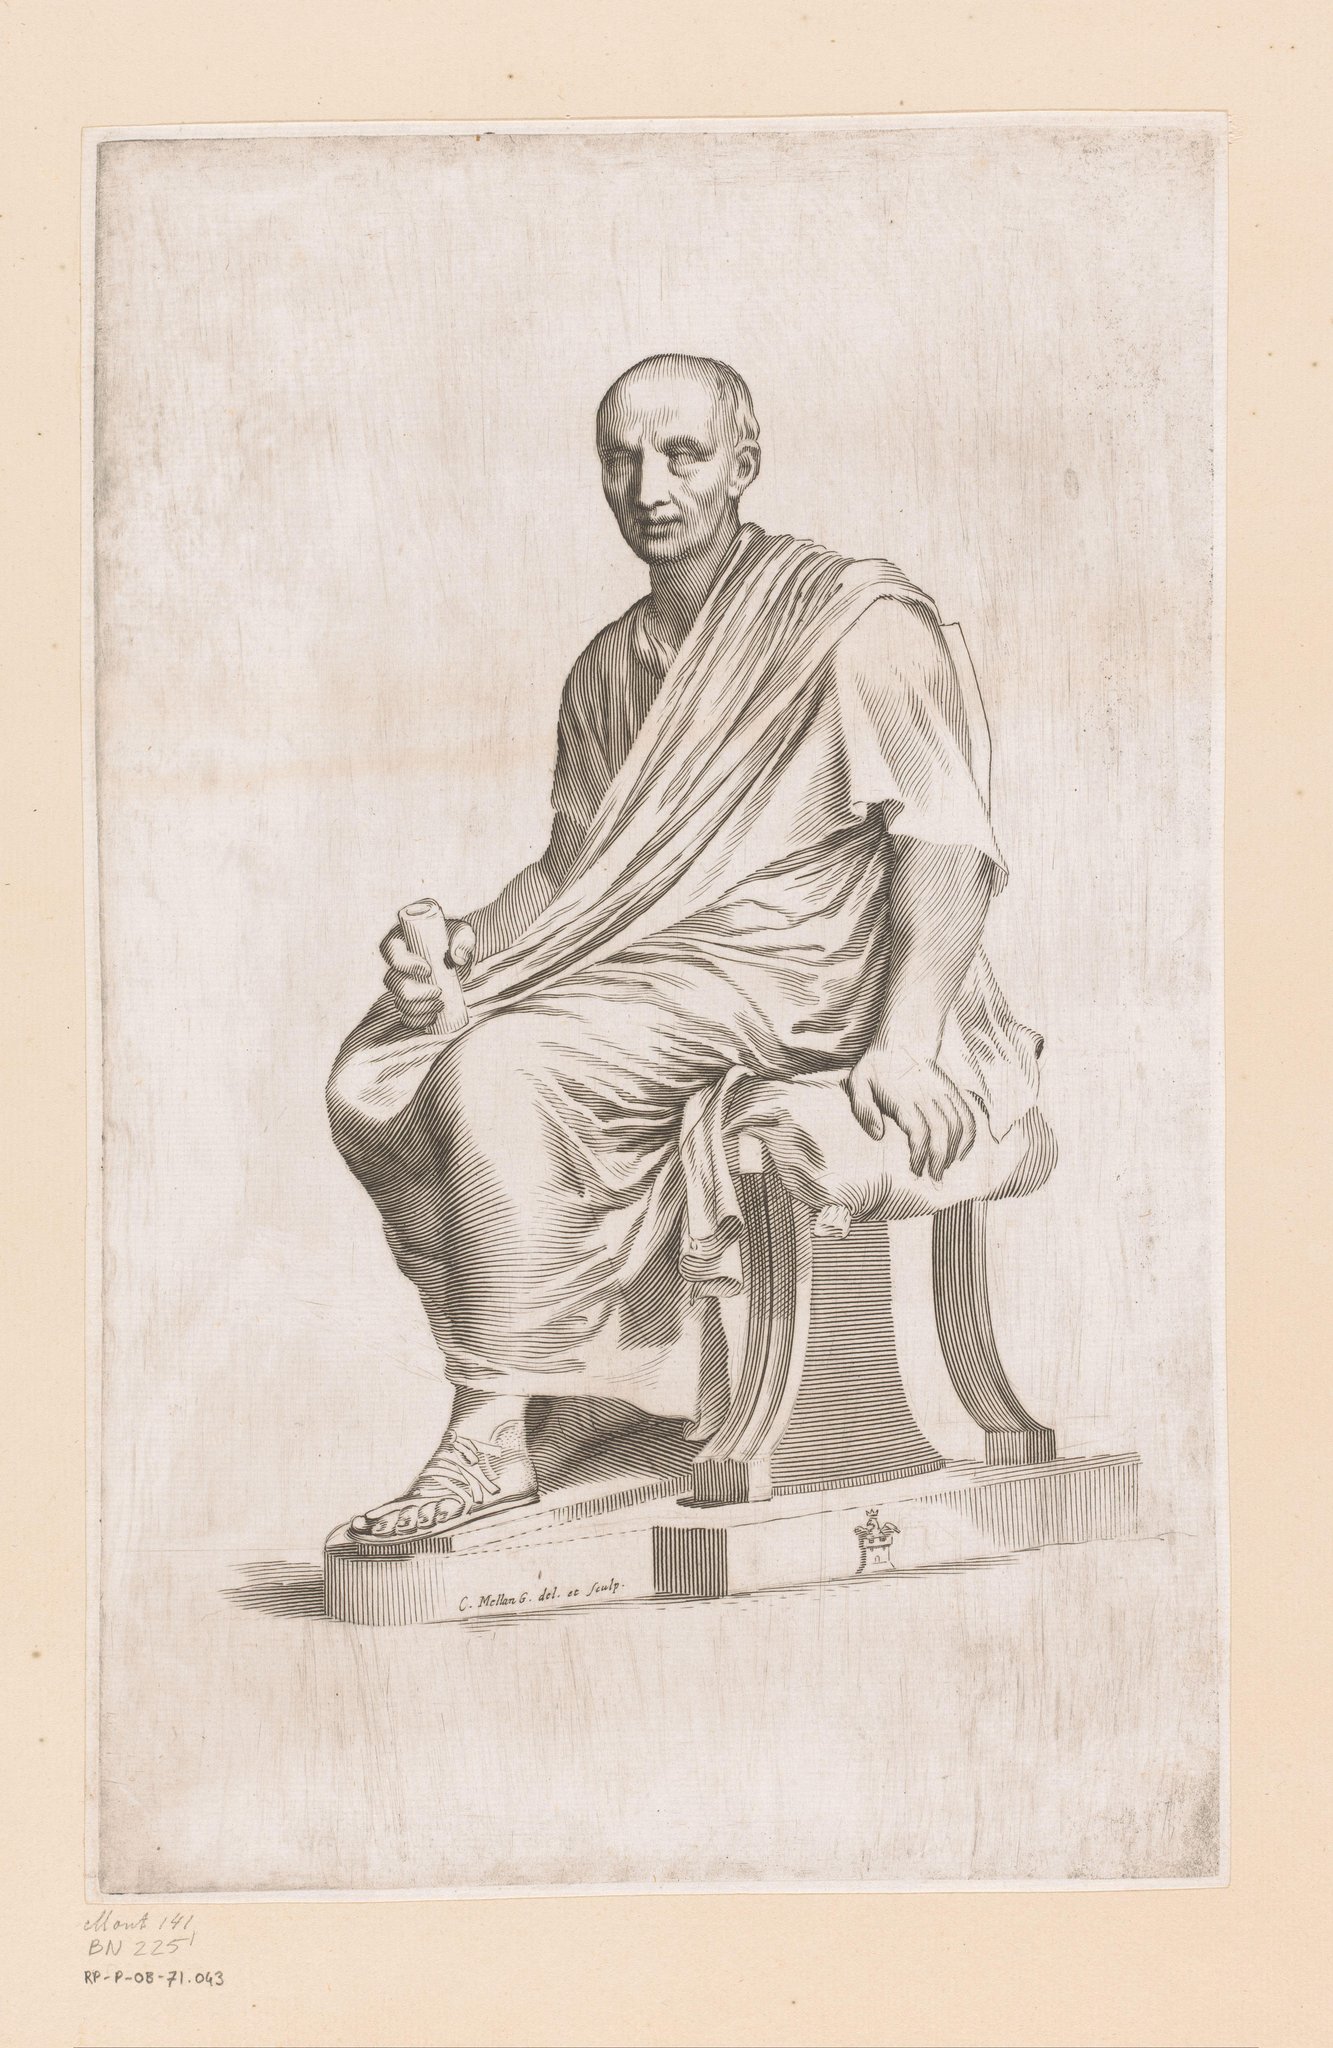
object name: print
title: Galleria Giustiniana del Marchese Vincenzo Giustiniani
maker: claude mellan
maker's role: draughtsman, print maker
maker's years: 1598-1688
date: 1631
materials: paper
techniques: engraving, intaglio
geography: rome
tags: rome, vincenzo giustiniani (1564-1637), sitting figure, piece of sculpture, reproduction of a piece of sculpture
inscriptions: collector's mark: Lugt 240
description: Maakt deel uit van een serie bestaande uit 322 prenten van kunstwerken uit de collectie van Vincenzo Giustiniani die in twee volumes werd uitgegeven door Joachim von Sandrart in 1636 en 1637 (zie British Museum, inv.nr. 1851,1213.565). De serie bestaat uit prenten door verschillende kunstenaars zoals Cornelis Bloemaert, Theodore Matham, Pieter de Bailliu en Michel Natalis. Claude Mellan was verantwoordelijk voor 22 prenten van standbeelden en het 1631 gedateerde portret van Giustiniani.